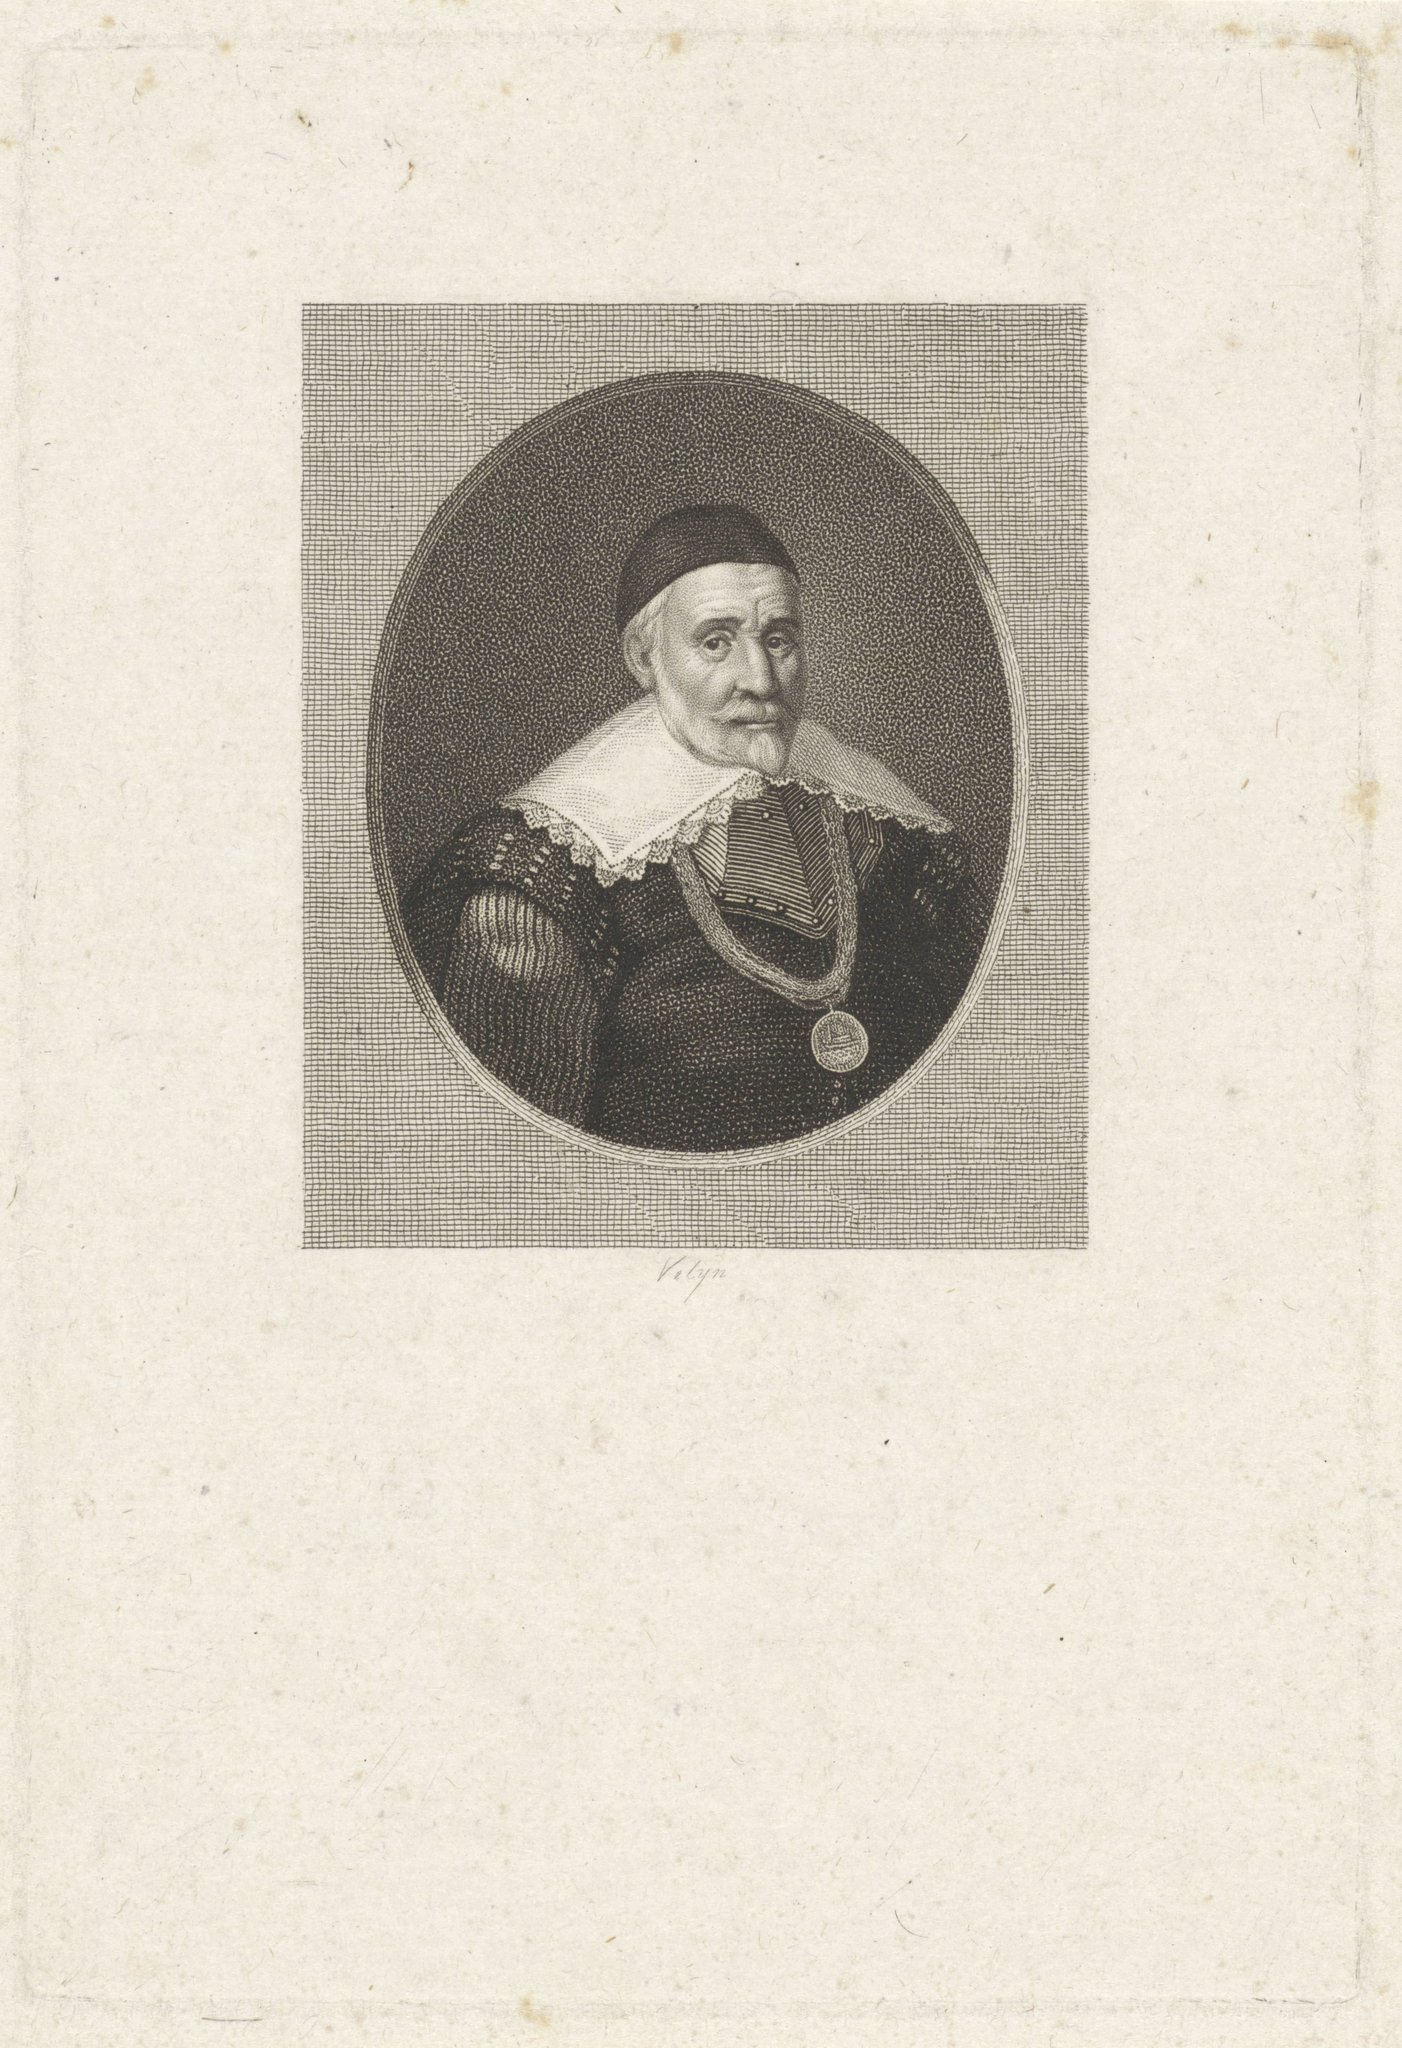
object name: print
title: Portret van Adriaen Joosten van Bergen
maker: philippus velijn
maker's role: print maker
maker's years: 1787-1836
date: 1797-1836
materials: paper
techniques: etching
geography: netherlands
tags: dordrecht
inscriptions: collector's mark: Lugt 2228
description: Portret van Adriaen Joosten van Bergen, een van de turfschippers van Breda. Van Bergen bracht op 4 maart 1590 met zijn vracht turf voor de Spaanse bezetters ook 72 Staatse soldaten de stad Breda binnen. Zij heroverden de vesting op de Spanjaarden en brachten stad en kasteel weer in handen van prins Maurits.